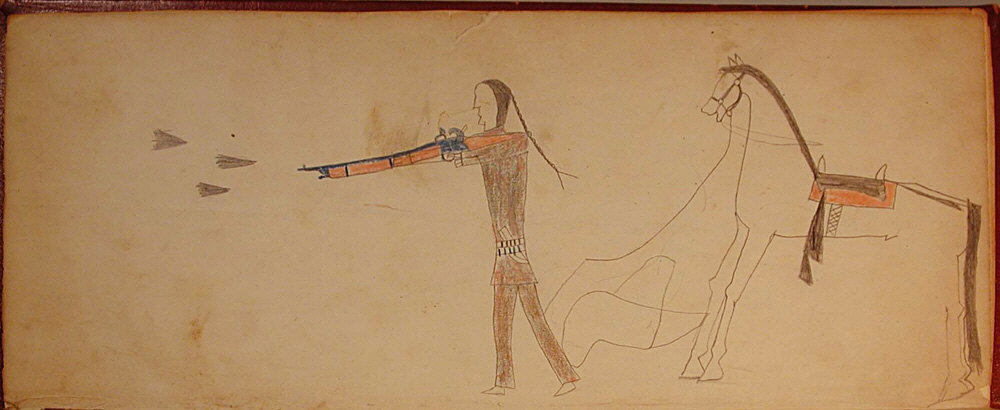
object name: drawing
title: Maffet Ledger: Indian Shooting Gun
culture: cheyenne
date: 1874-1881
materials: crayon, graphite, paper, watercolor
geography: united states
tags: human figures,horses